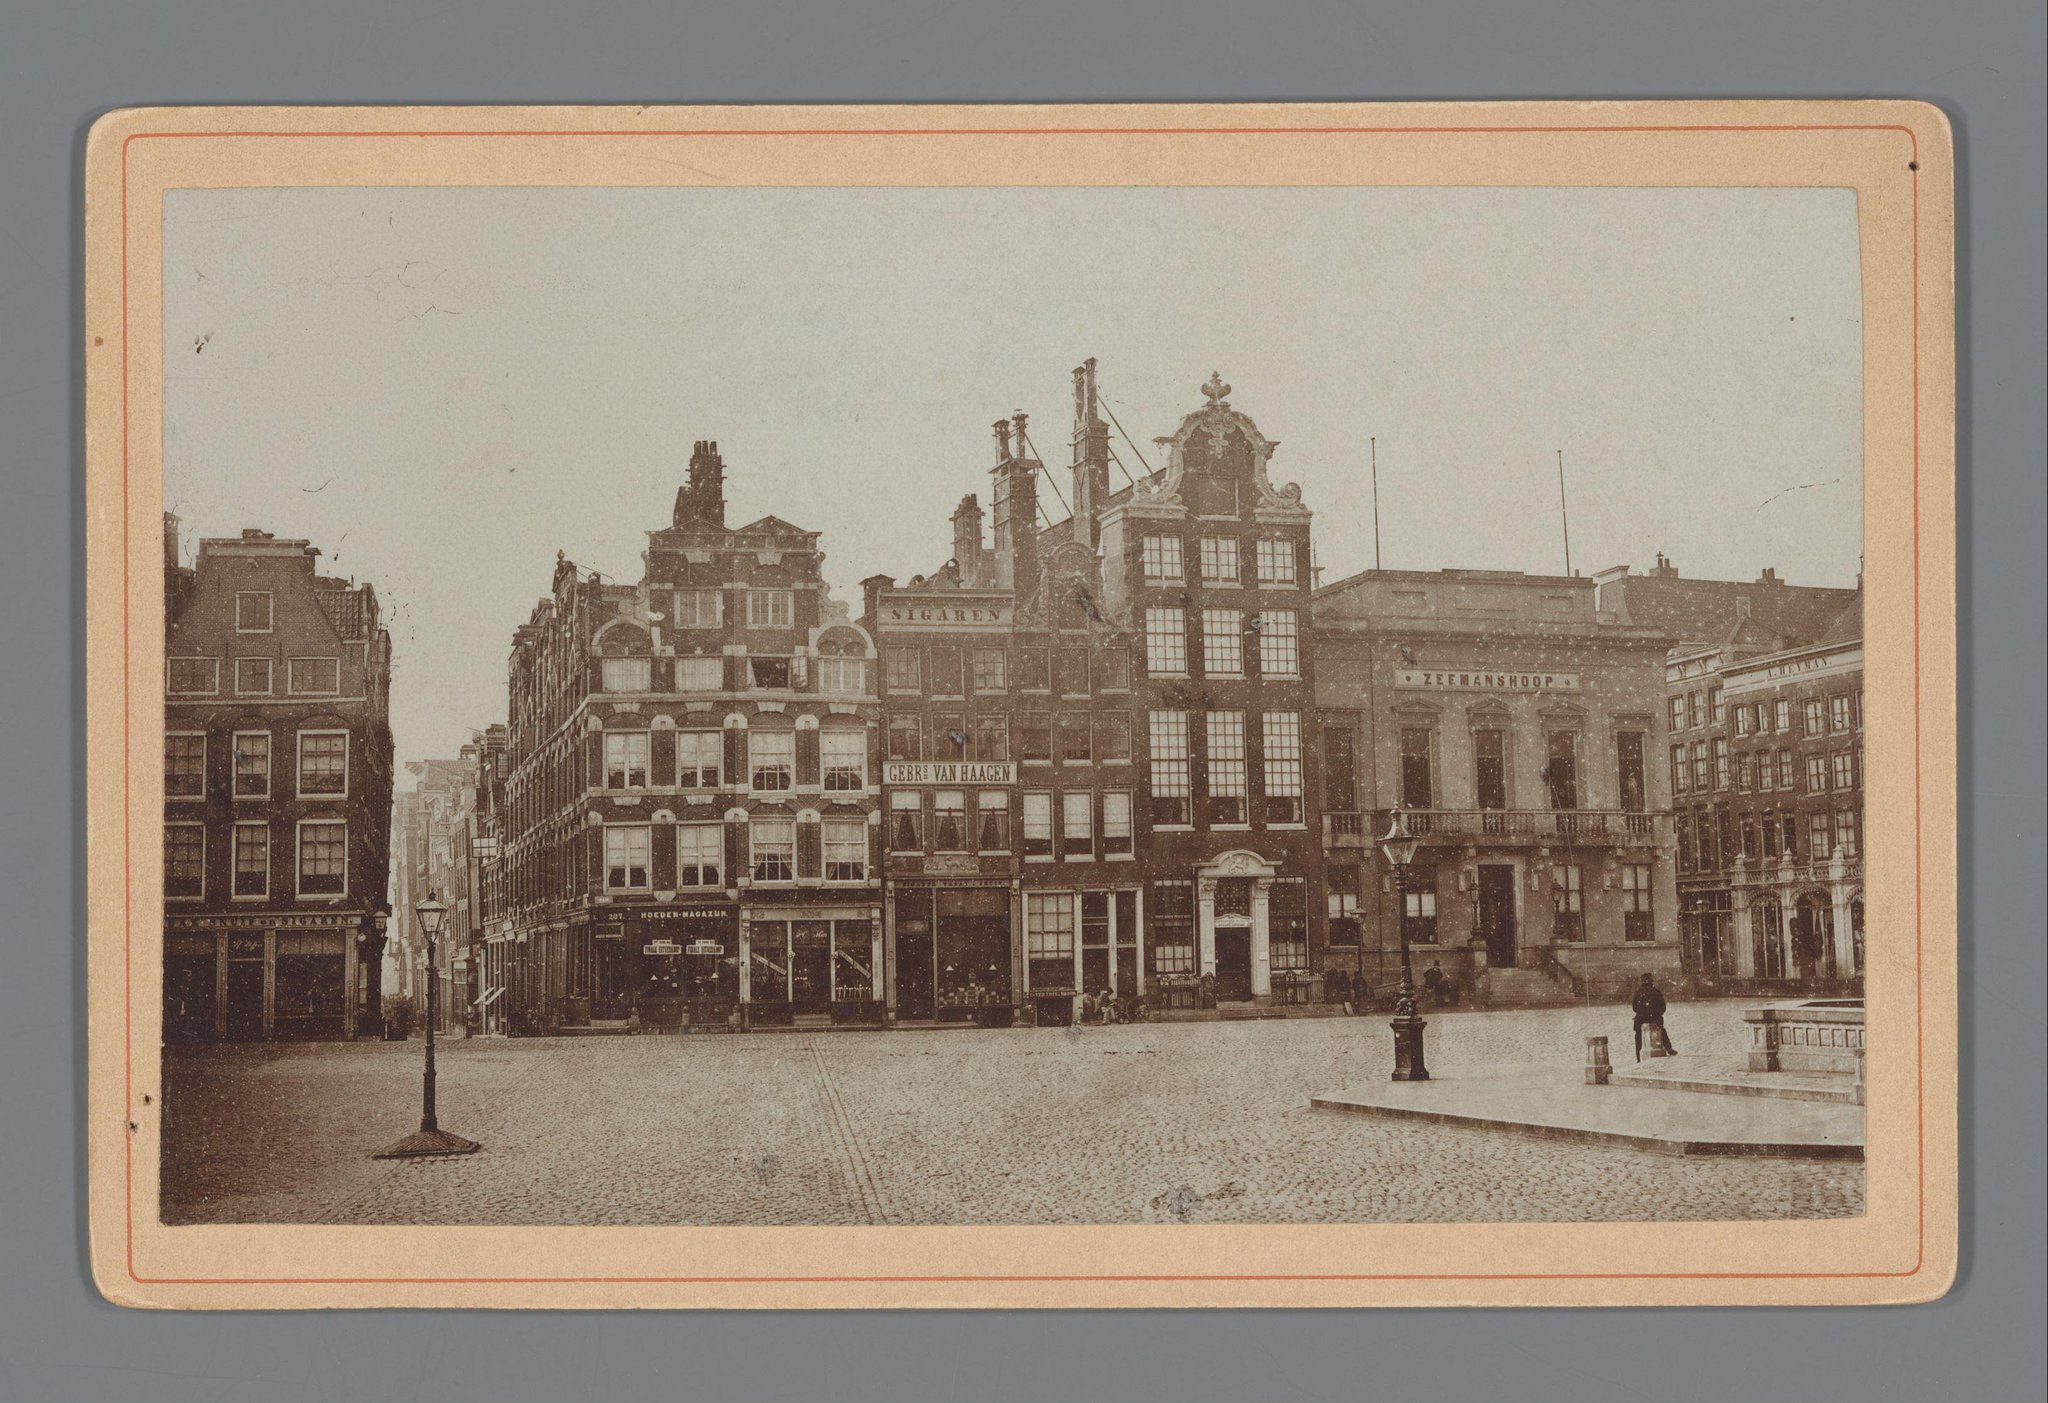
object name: photograph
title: Gezicht op de Dam te Amsterdam met de voormalige Beurssteeg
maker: Anonymous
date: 1890-1910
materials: cardboard, photographic support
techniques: collodion silver print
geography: amsterdam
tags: square, place, circus, etc., civic architecture; edifices; dwellings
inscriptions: retailer's mark: ‘Gebr. Douwes/ Ateliers en Kunsthandel/ Warmoesstraat 73/ en Damrak 69/ Amsterdam’, annotation: ‘De Dam, ziende op de Oude huizen/ met voormalige Beurssteeg - afgebroken voor de verbreeding met het Rokin’, number: ‘33’